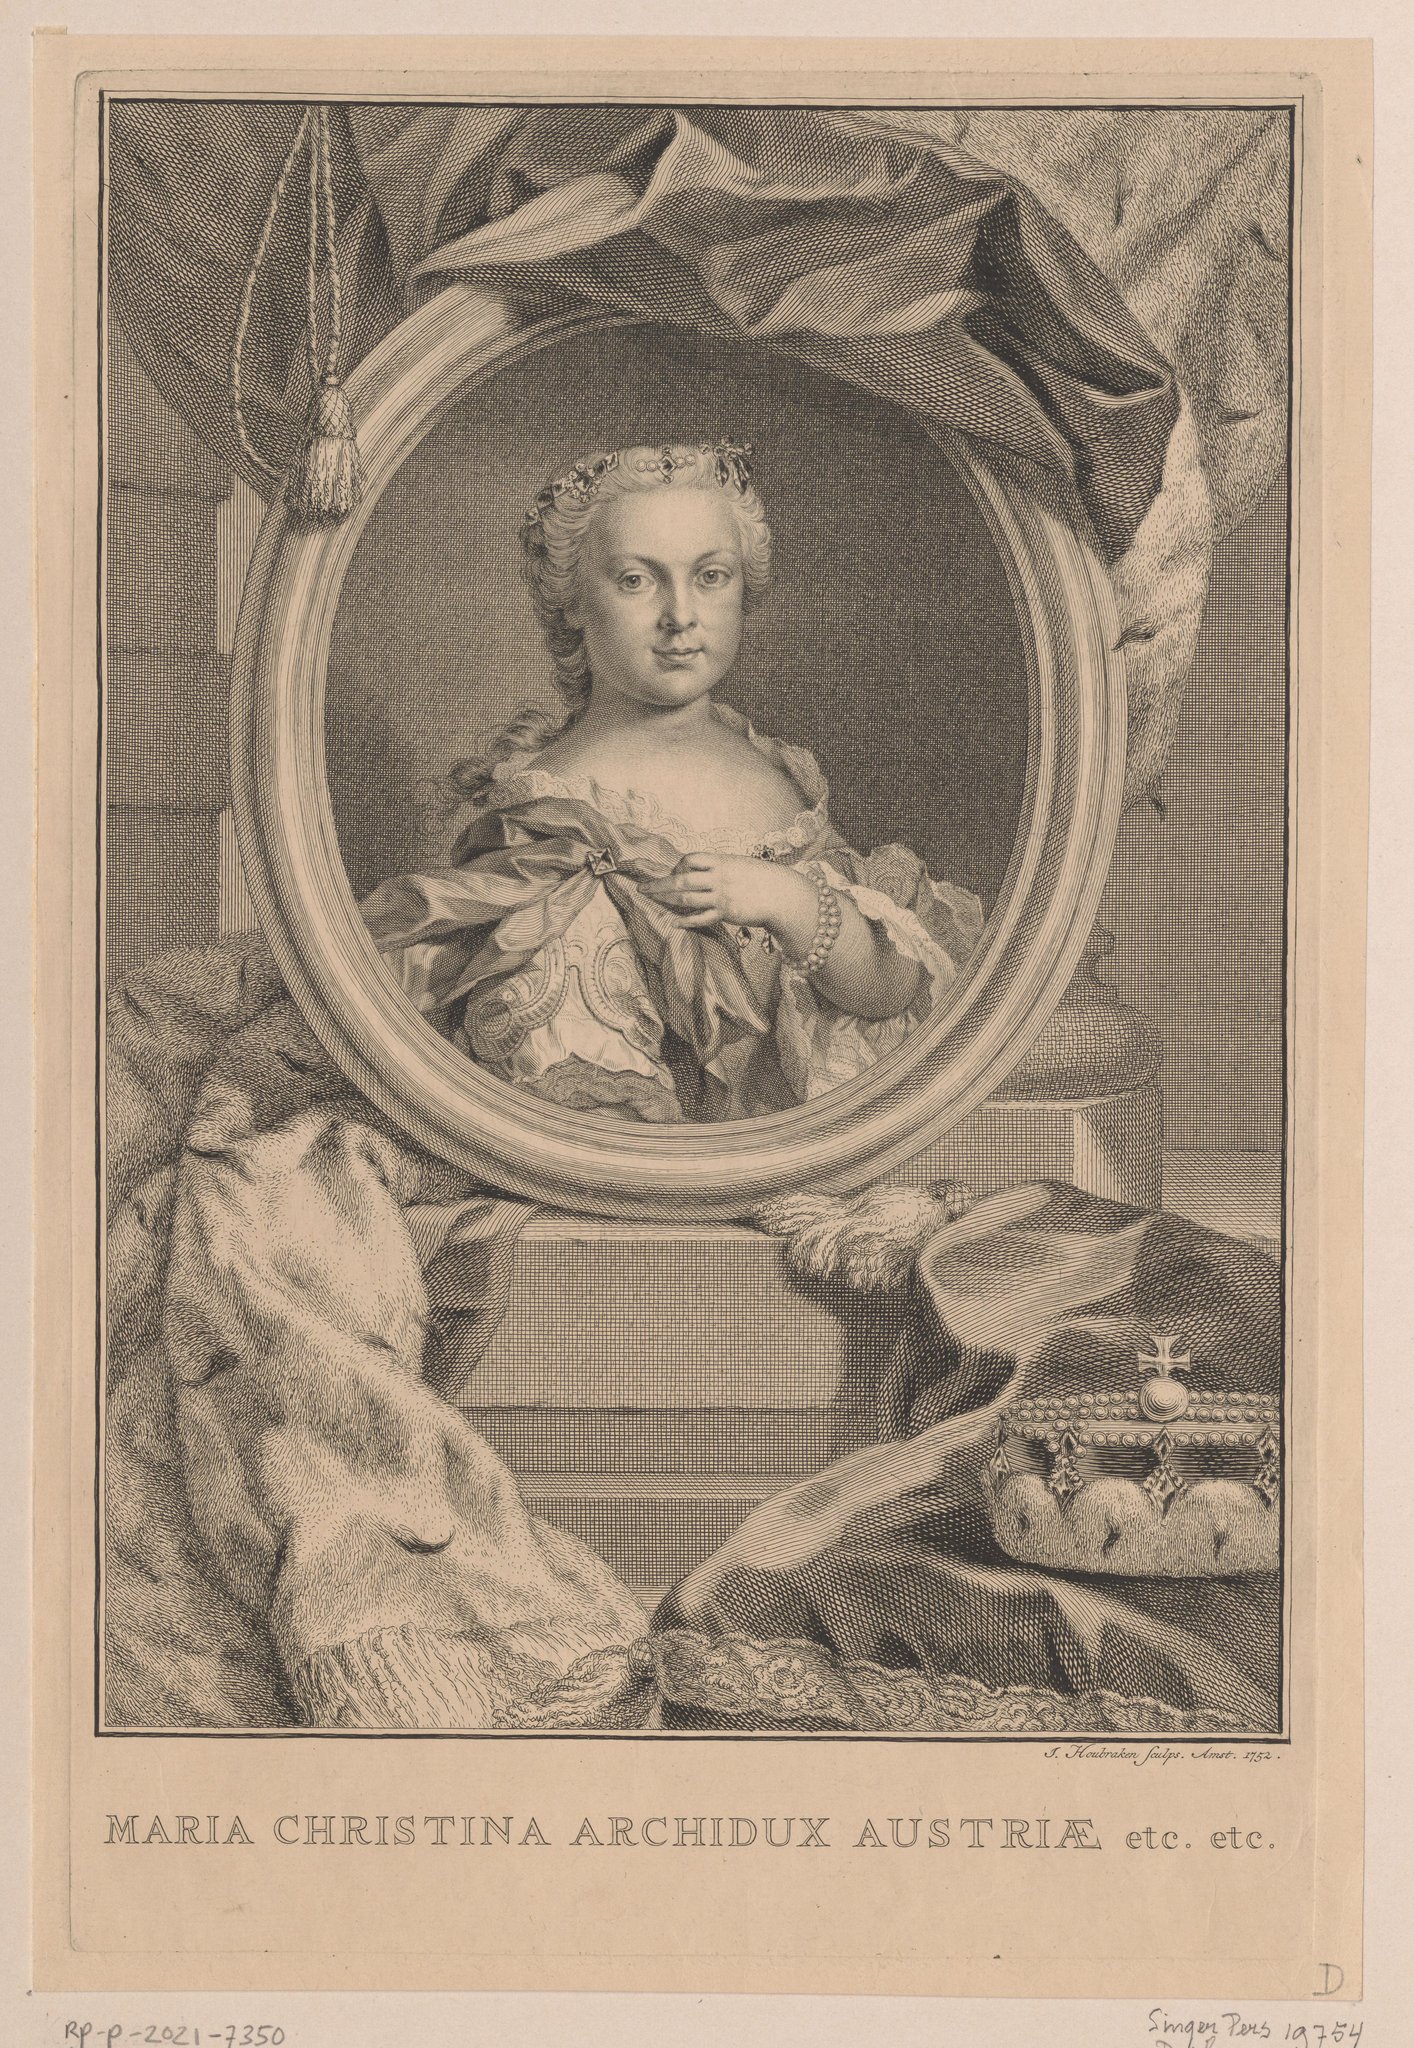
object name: print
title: Portret van Maria Christina van Oostenrijk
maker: jacob houbraken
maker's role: draughtsman, print maker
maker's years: 1698-1780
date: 1752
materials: paper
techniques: engraving, etching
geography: amsterdam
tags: maria christina van oostenrijk (1742-1798), crown (symbol of sovereignty), historical persons - bb - woman, ornament ~ medallion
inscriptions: collector's mark: Lugt 240